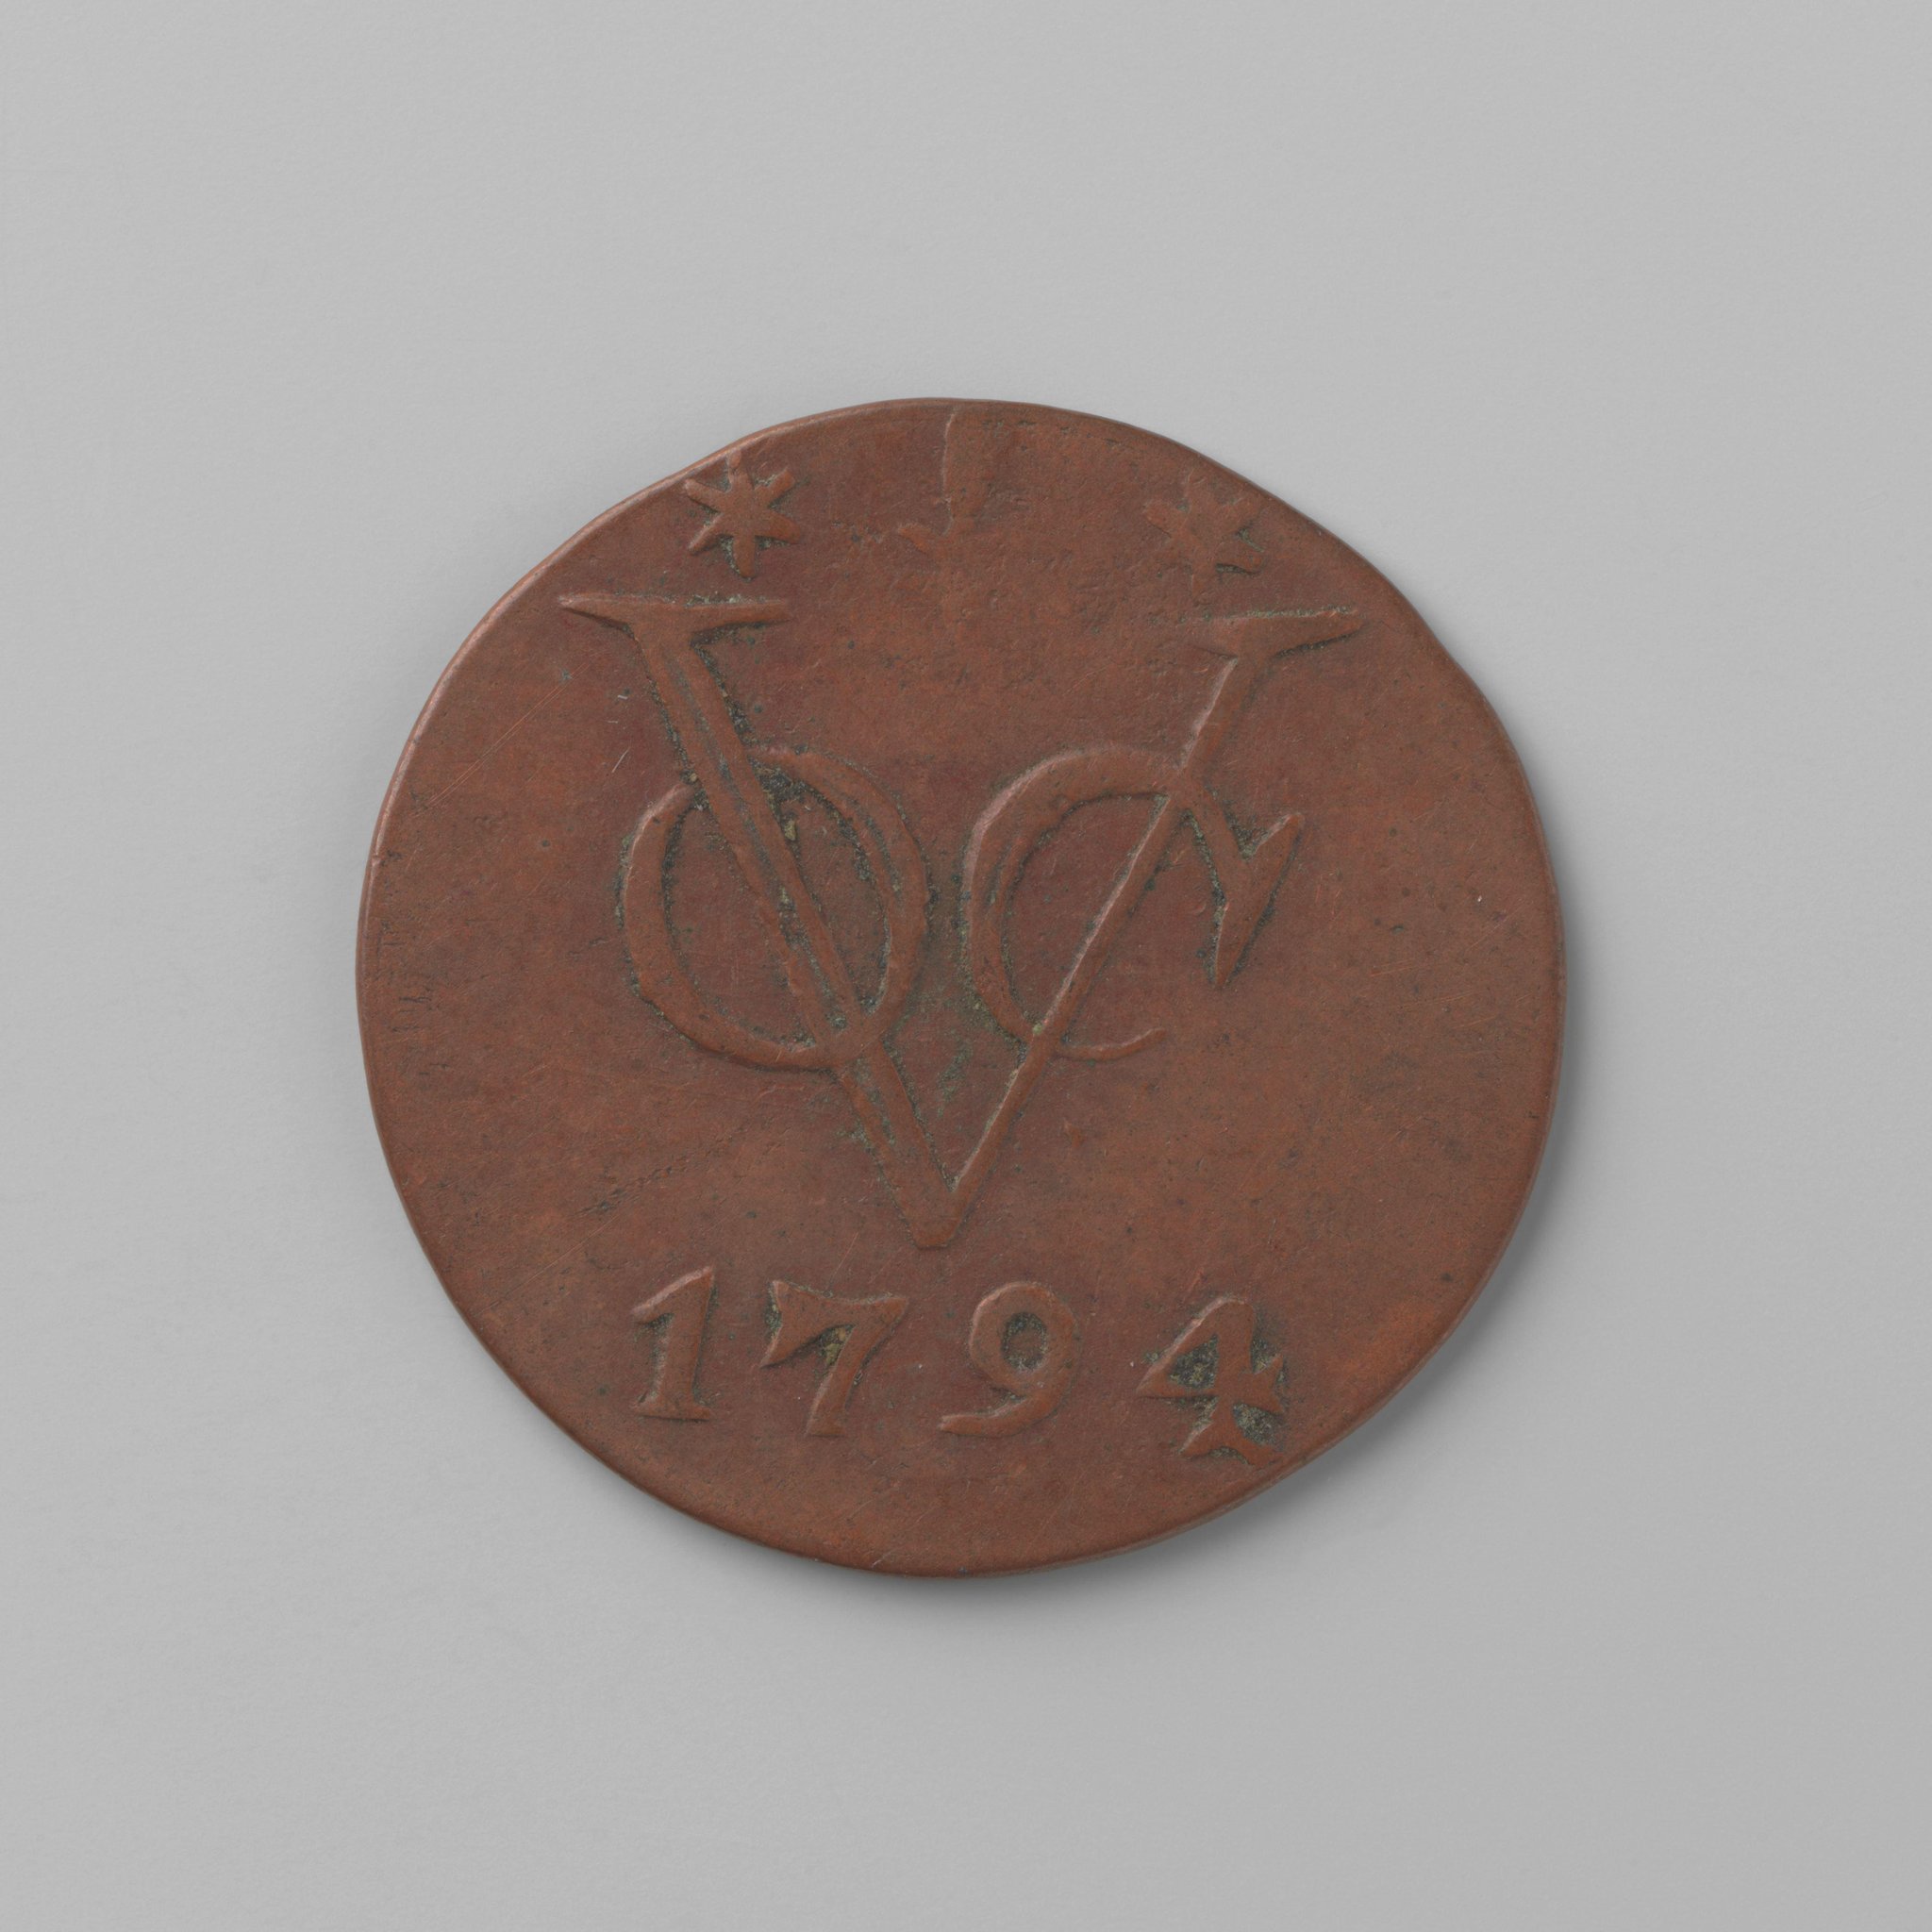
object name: coin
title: Duit van de VOC uit Gelderland,1794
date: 1794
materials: copper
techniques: striking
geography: harderwijk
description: Koperen munt. Voorzijde: tussen wapenspreuk gekroond wapenschild van Gelderland. Keerzijde: monogram van de VOC, waarboven muntmeesterteken en waaronder jaartal. Gladde rand.